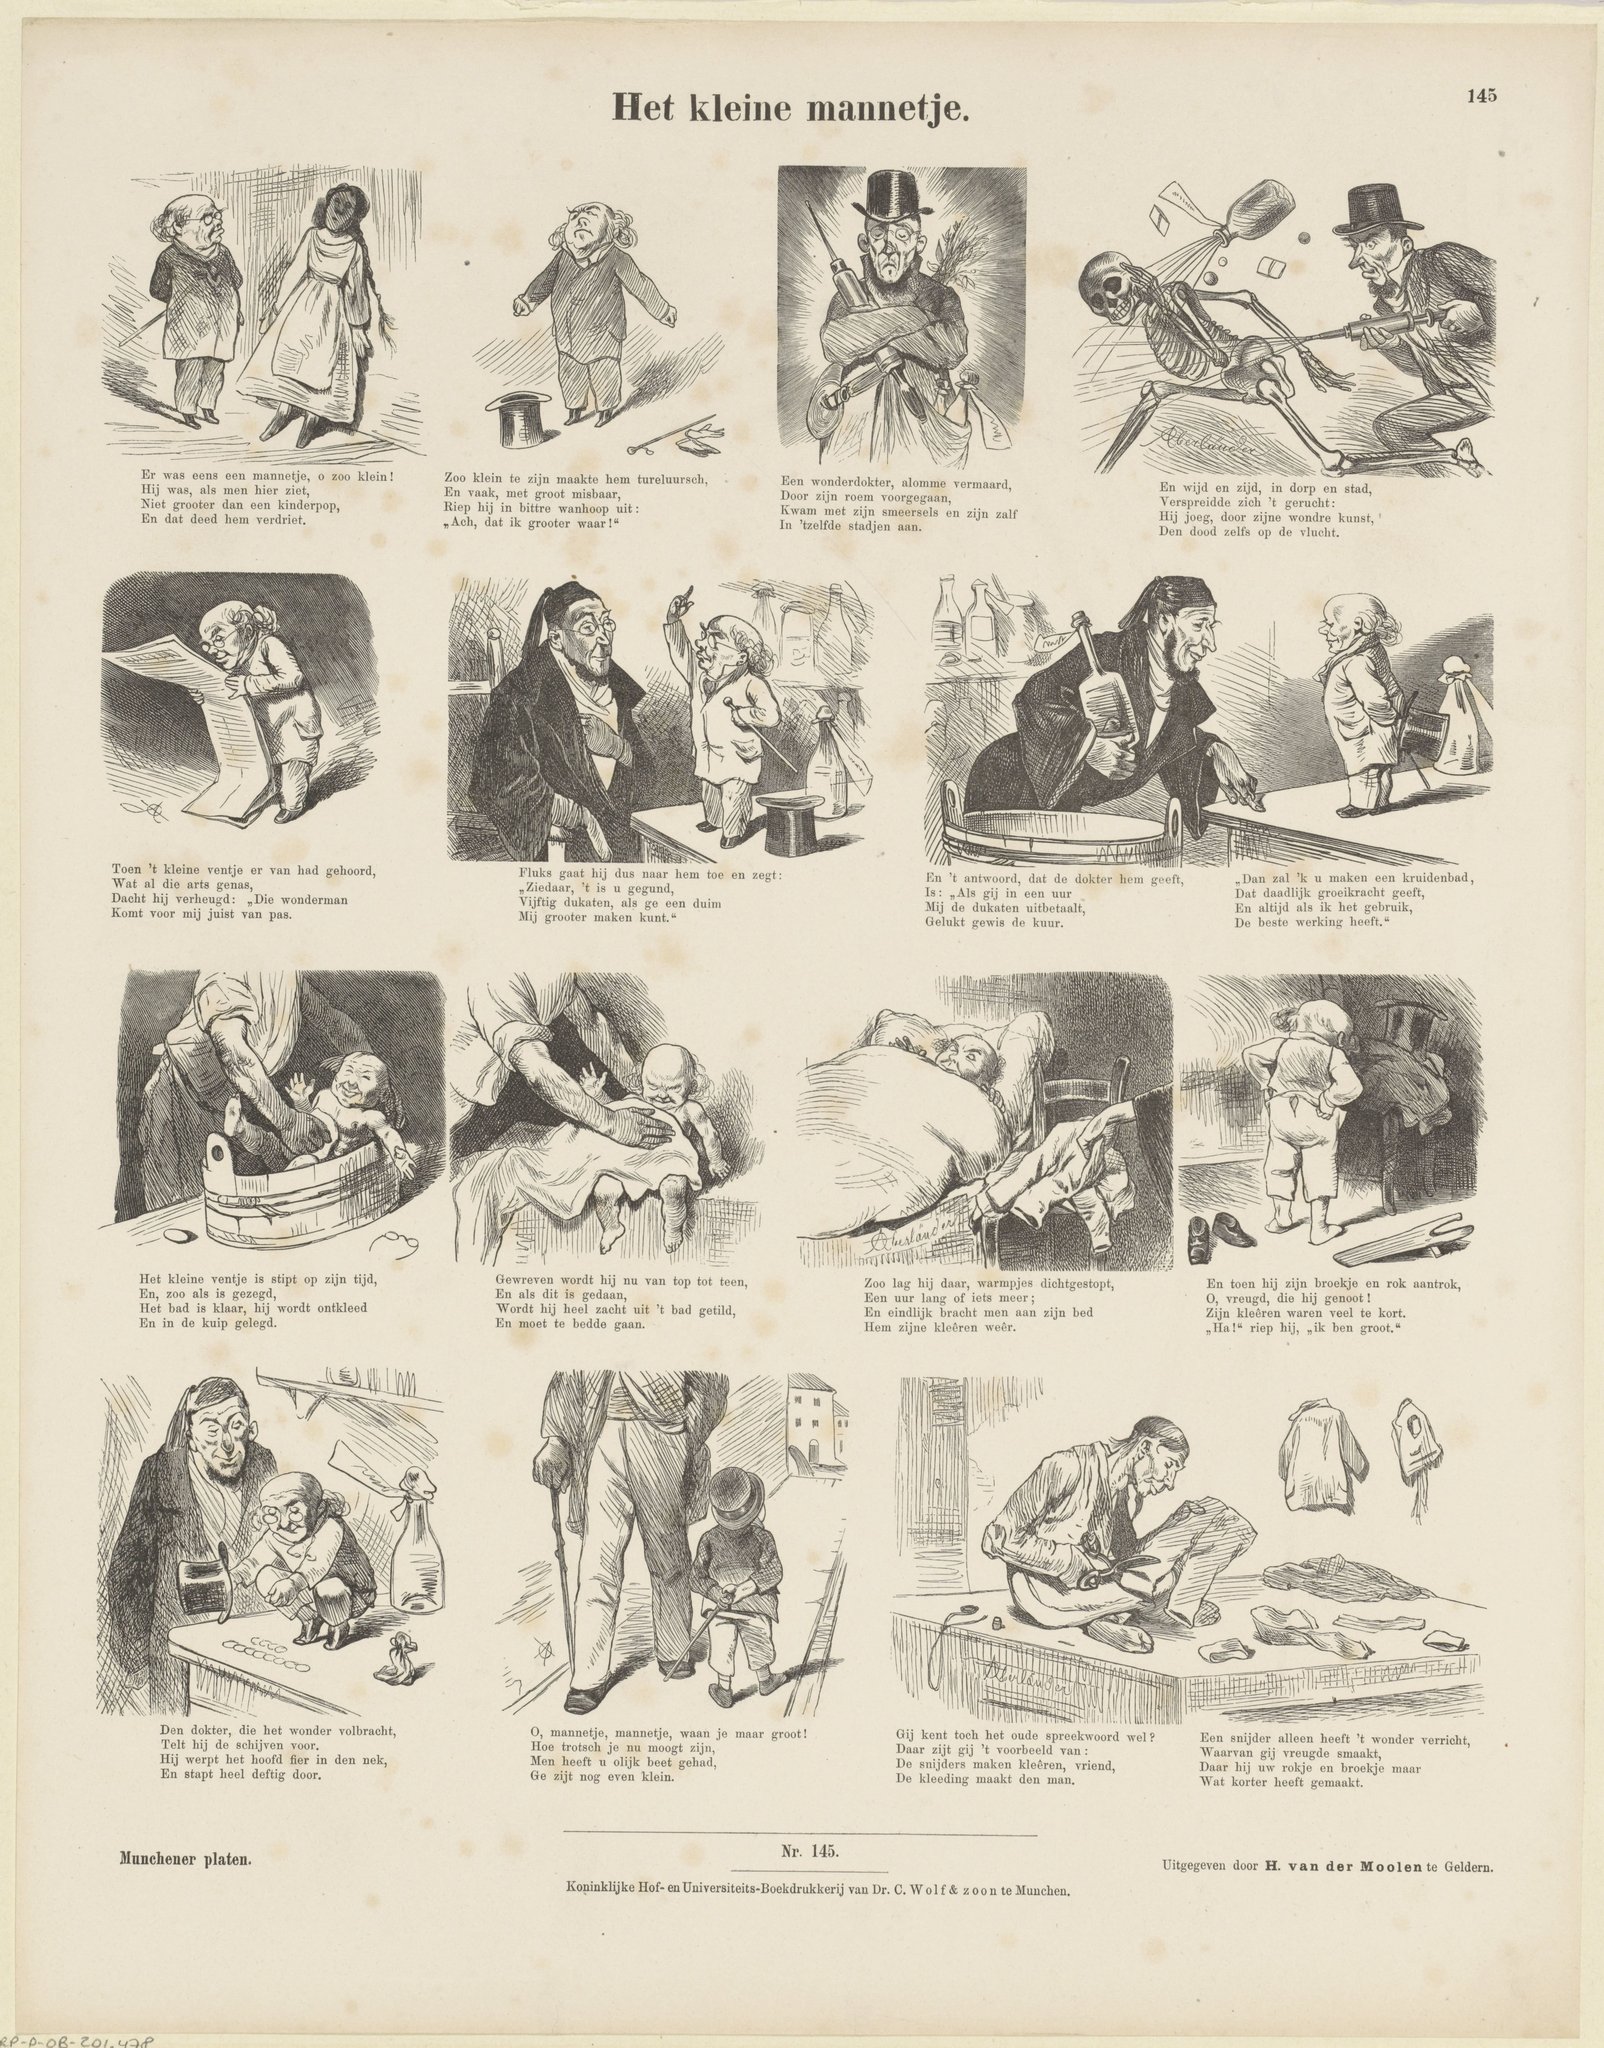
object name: print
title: Het kleine mannetje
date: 1843-1920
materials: paper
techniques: letterpress printing, engraving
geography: geldern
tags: quack, charlatan, mountebank, 'saltimbanco', tailor, dressmaker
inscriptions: collector's mark: Lugt 2760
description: Blad met 17 voorstellingen over een klein mannetje die door een kwakzalver wordt bedrogen. Hij denkt te zijn gegroeid, terwijl in feite zijn kleren kleiner zijn gemaakt. Onder elke afbeelding een vers. Genummerd midden onder: Nro. 145. Genummerd rechtsboven: 145.